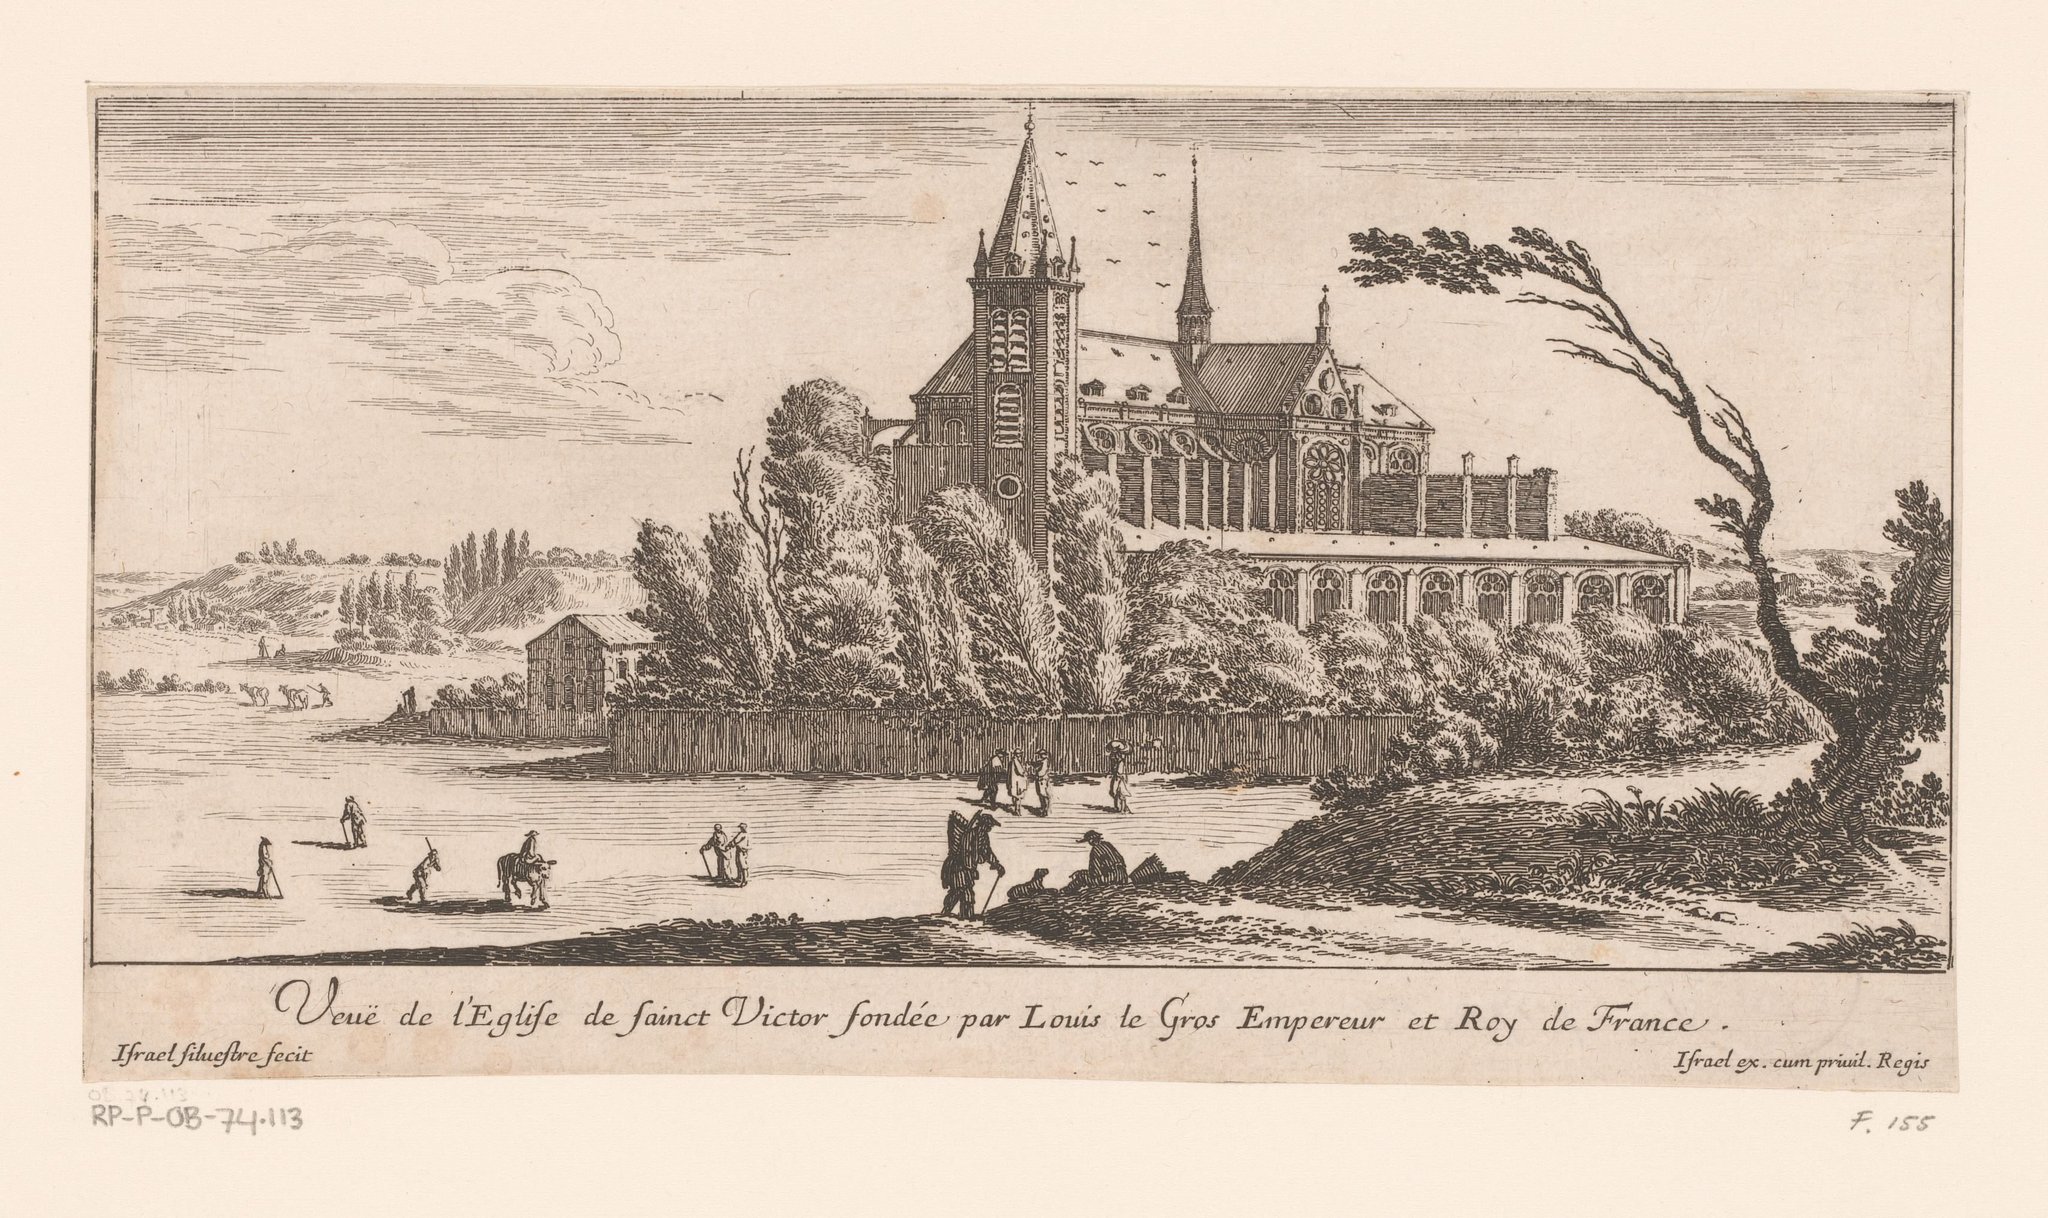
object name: print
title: Veue de l'Eglise de sainct Victor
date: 1655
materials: paper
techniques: etching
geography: france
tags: church (exterior), landscape with tower or castle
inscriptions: collector's mark: Lugt 240